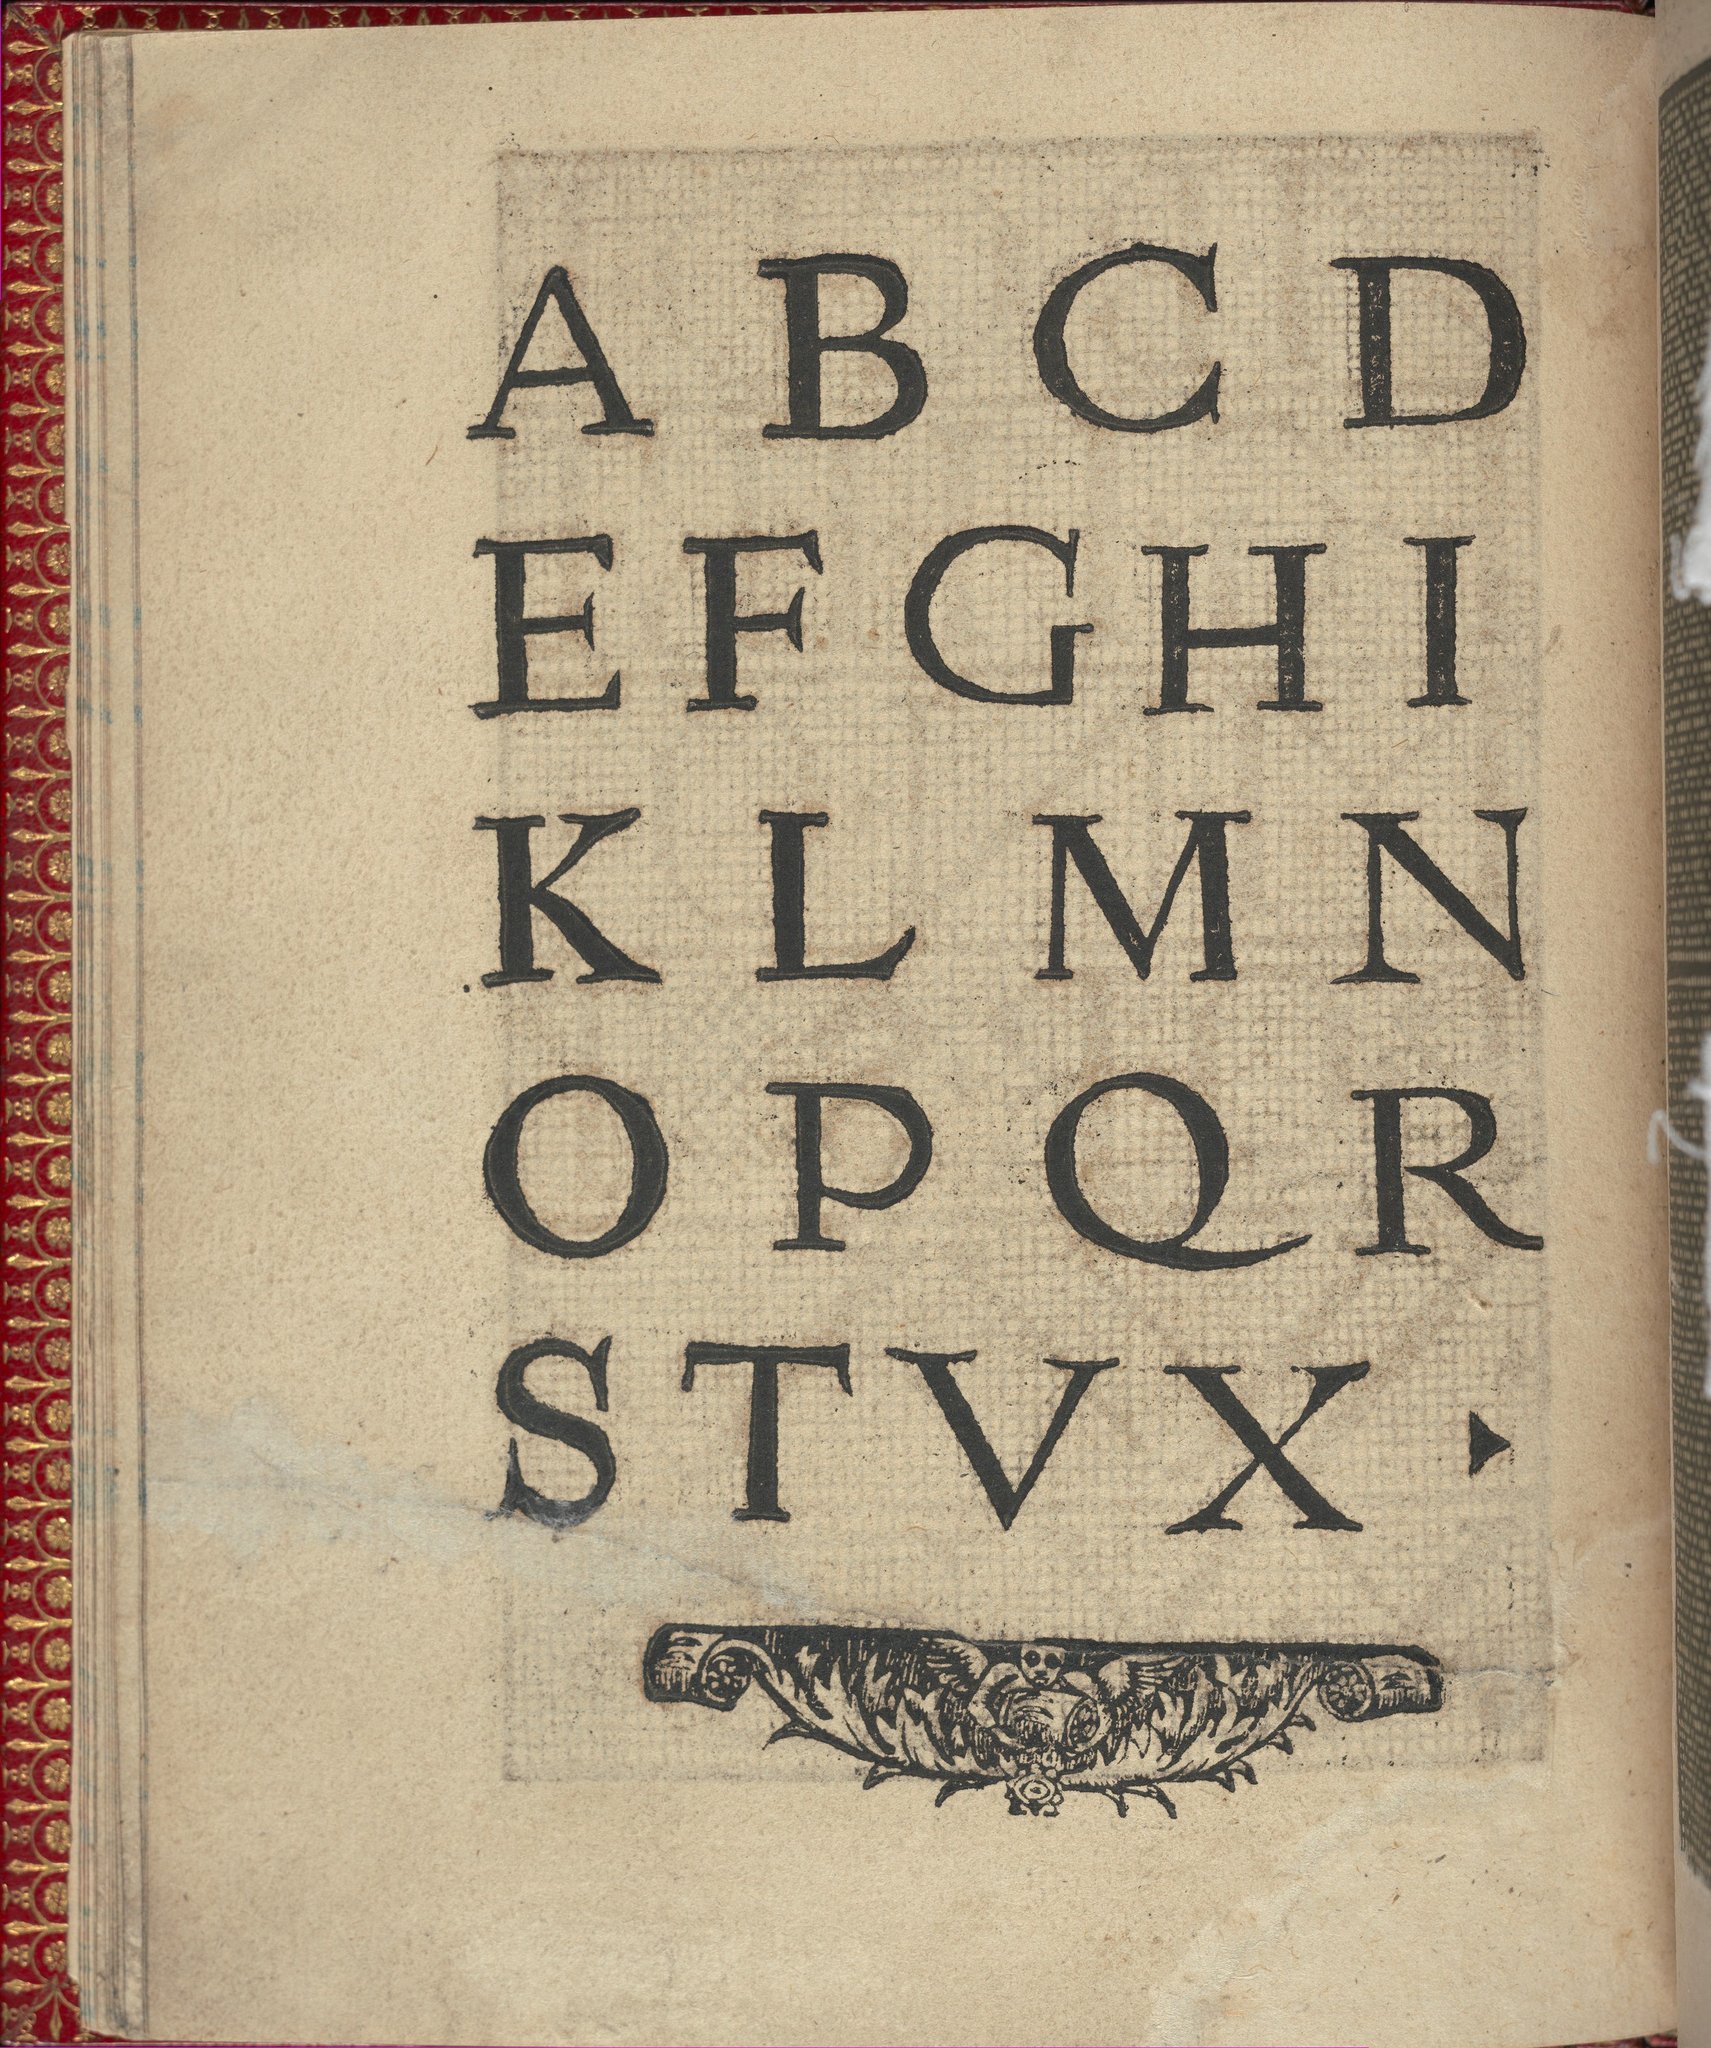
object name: book print ornament architecture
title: Ce est ung tractat de la noble art de leguille ascavoir ouvraiges de spaigne... page 13 (verso)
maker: willem vosterman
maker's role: printer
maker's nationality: netherlandish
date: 1527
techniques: woodcut